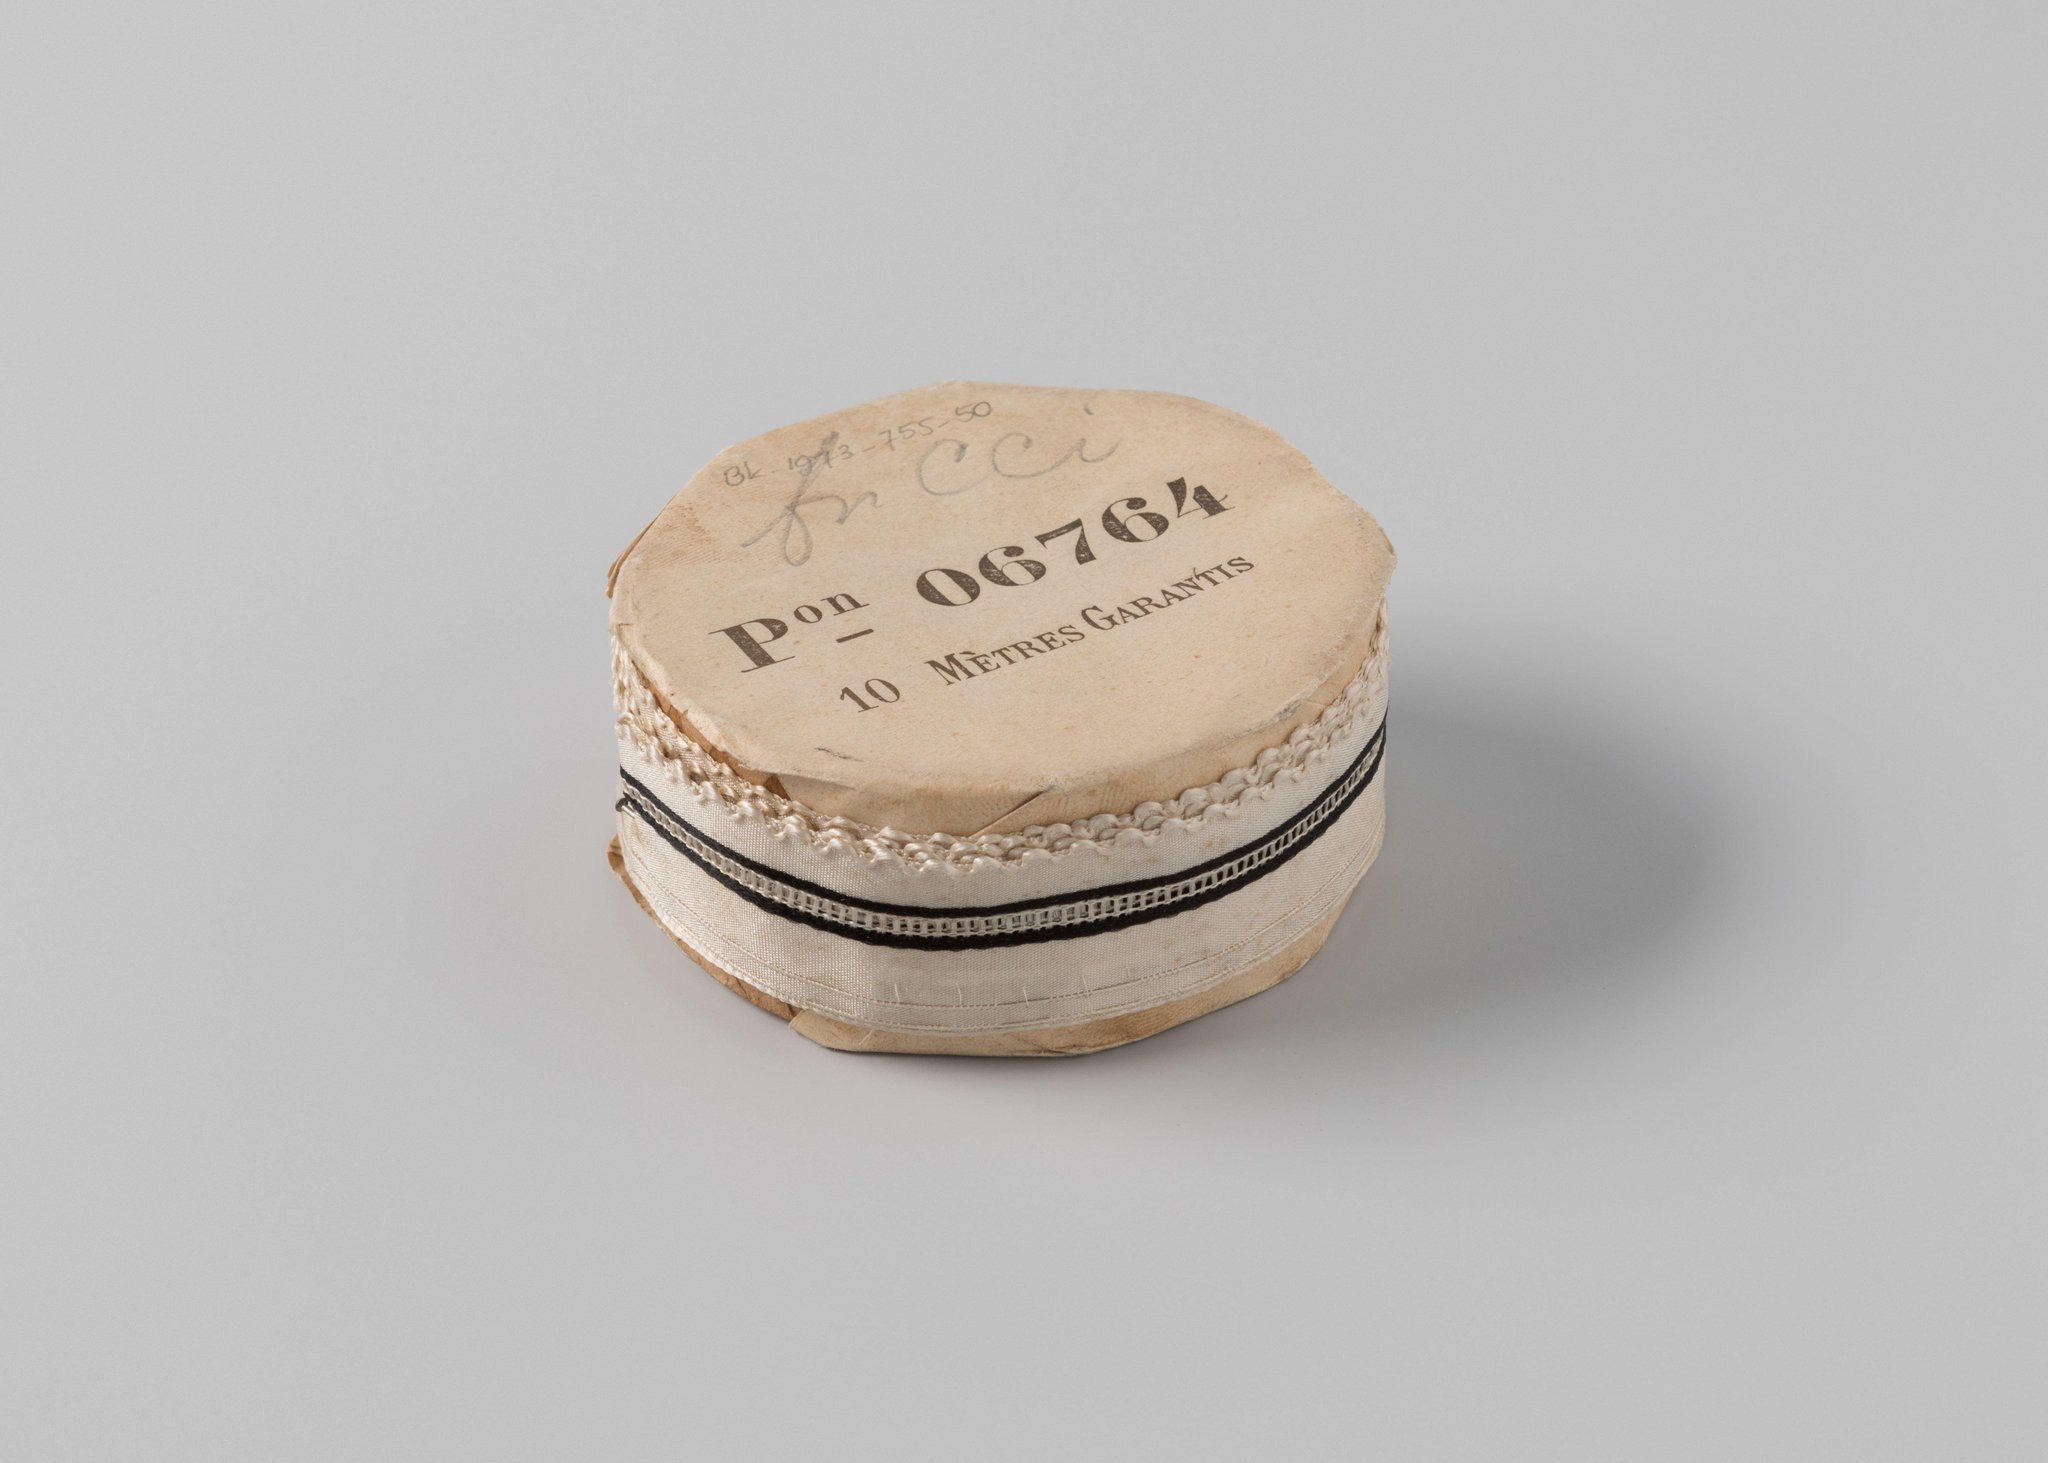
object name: ribbon material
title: Lint op rol, wit satijn met in het midden een streep ajourwerk gevat tussen twee strepen zwart, één zijde is geschulpt en afgezet met een golvende rand in wit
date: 1890-1935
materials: cardboard, paper, textile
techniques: embroidery, weave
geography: france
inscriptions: number: ‘Pon 06764’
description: Lint op rol, wit satijn met in het midden een streep ajourwerk gevat tussen twee strepen zwart, één zijde is geschulpt en afgezet met een golvende rand in wit.